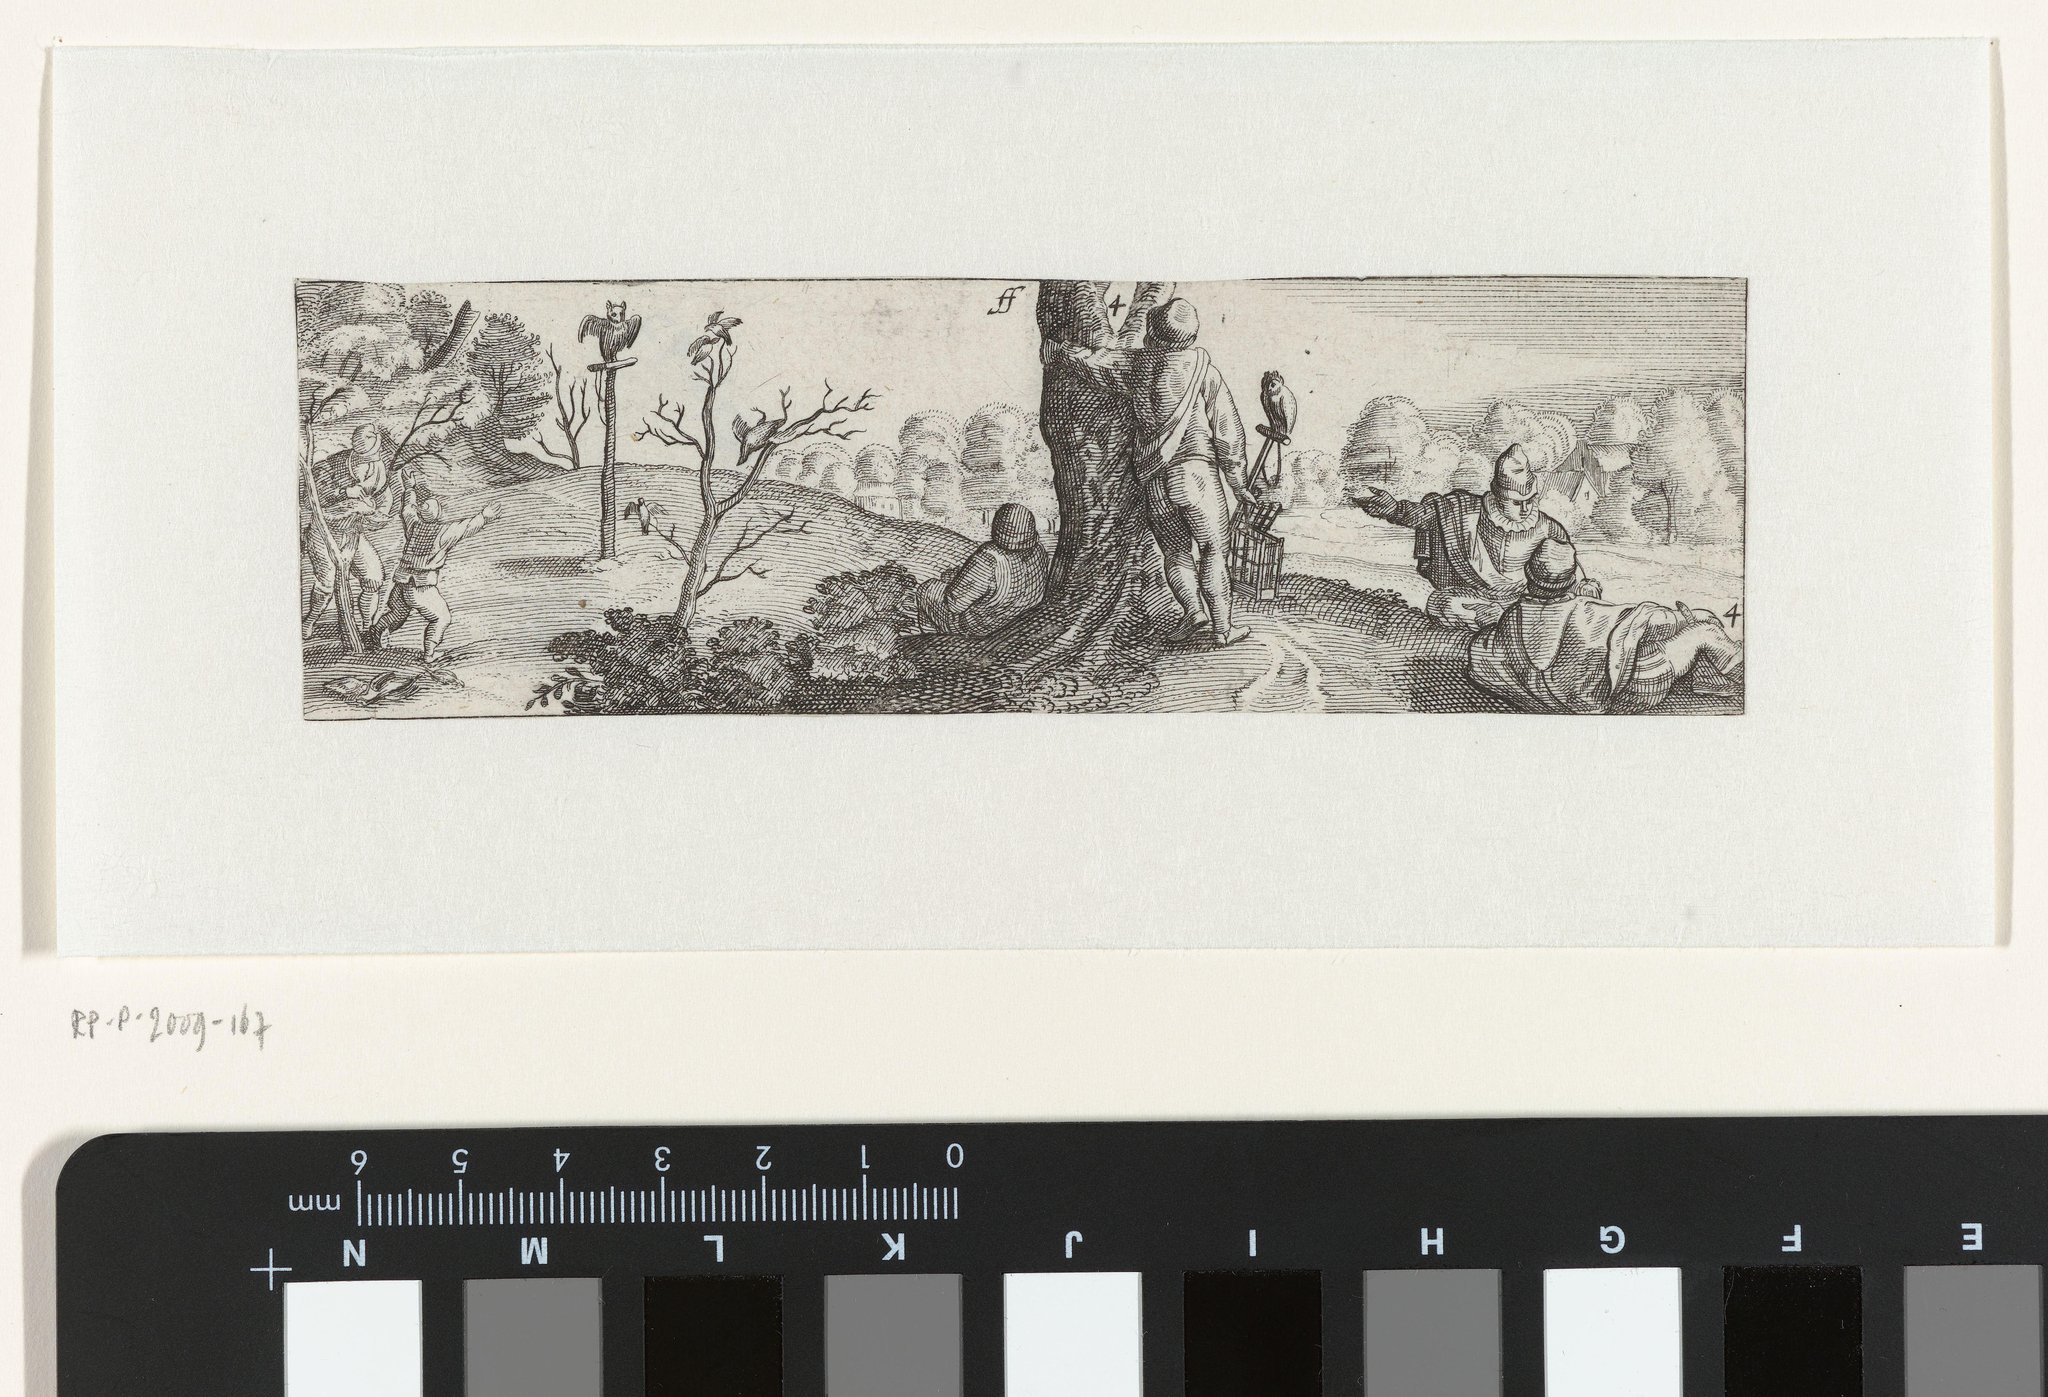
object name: print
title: Vogelvangers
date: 1601-1652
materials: paper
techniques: engraving, etching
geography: amsterdam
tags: bird hunting, owls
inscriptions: collector's mark: Lugt 2760, collector's mark: Lugt 2228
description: Twaalfde prent uit een serie van negentien met gezichten op de omgeving van Amsterdam. Landschap met vogelsvangers. Drie figuren liggen op een heuvel. Een figuur met vogelkooi in zijn hand leunt tegen een boom. Links op de achtergrond nog twee figuren.